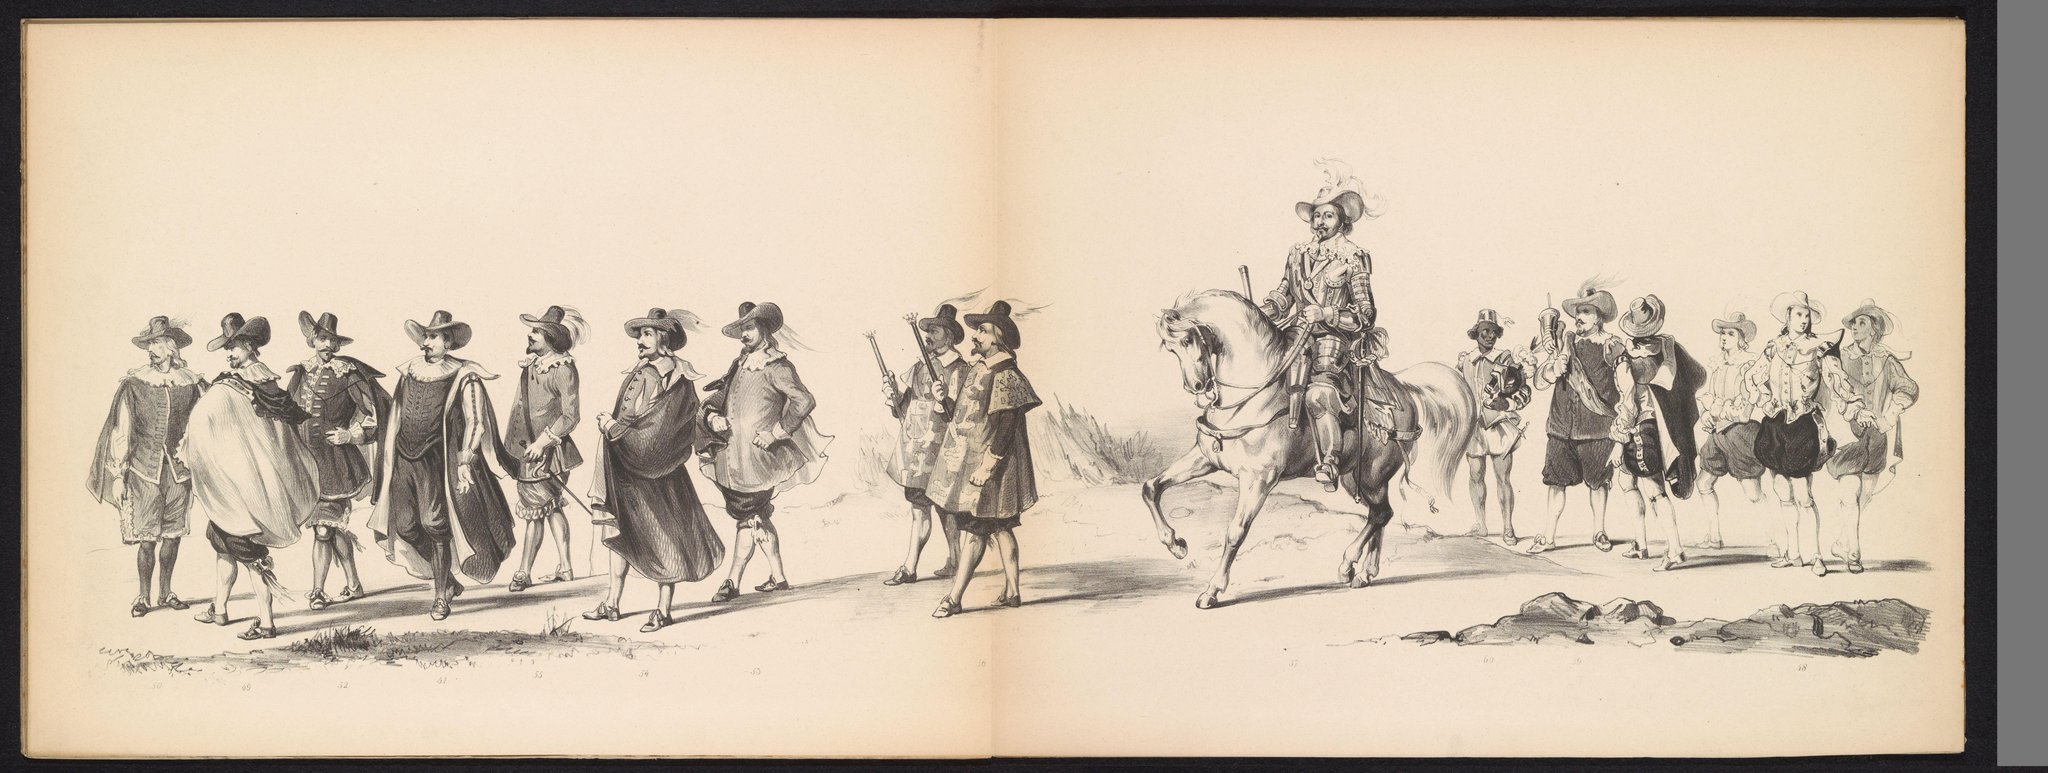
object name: text sheet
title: Maskerade van de Leidse studenten, 1850 (plaat 6)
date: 1850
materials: paper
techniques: lithograph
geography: leiden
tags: delft, frederick henry (prince of orange), students' pageant, costumes used in pageants, leiden, den bosch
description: Historische gekostumeerde optocht van de studenten van de Leidse Hogeschool op 11 juni 1850. De optocht verbeeldt de intocht van Frederik Hendrik te Den Bosch in 1629. Zesde plaat met de groepen genummerd 49-60. Onderdeel van de serie van dertien aanelkaar geplakte bladen.